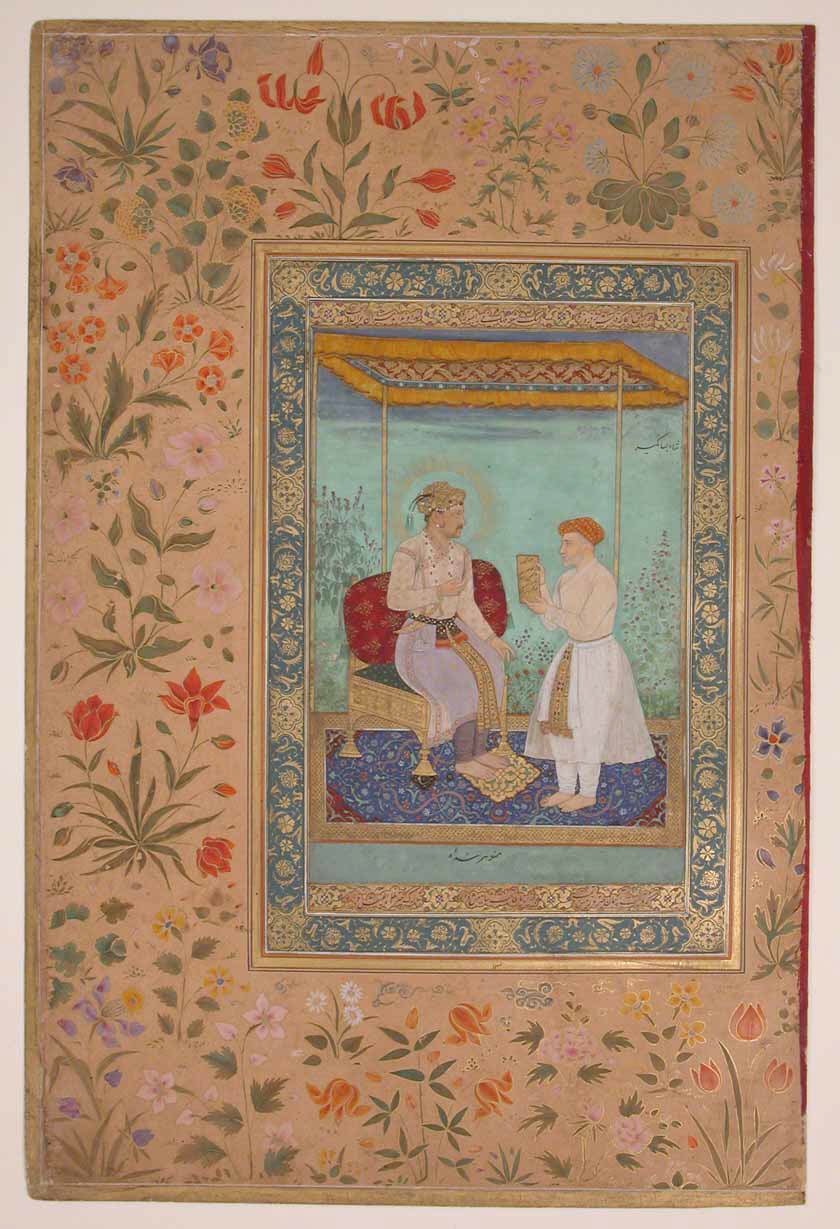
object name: album leaf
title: "Jahangir and His Vizier, I'timad al-Daula", Folio from the Shah Jahan Album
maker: manohar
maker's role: artist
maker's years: 1577-1624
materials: gold, ink, paper, watercolor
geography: india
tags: poetry,persian,calligraphy